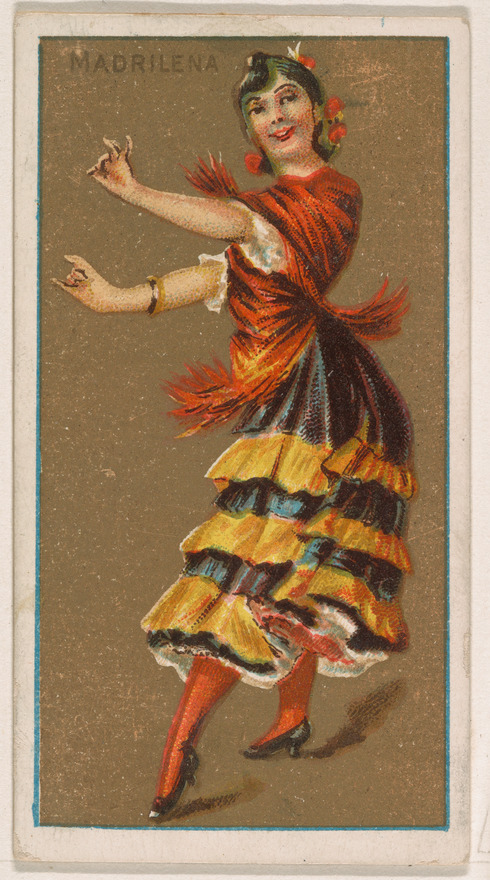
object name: print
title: Madrilena, from National Dances (N225, Type 1) issued by Kinney Bros.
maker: kinney brothers tobacco company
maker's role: publisher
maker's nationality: american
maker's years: 1869-2011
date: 1889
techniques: color lithograph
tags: women,dancing,dancers